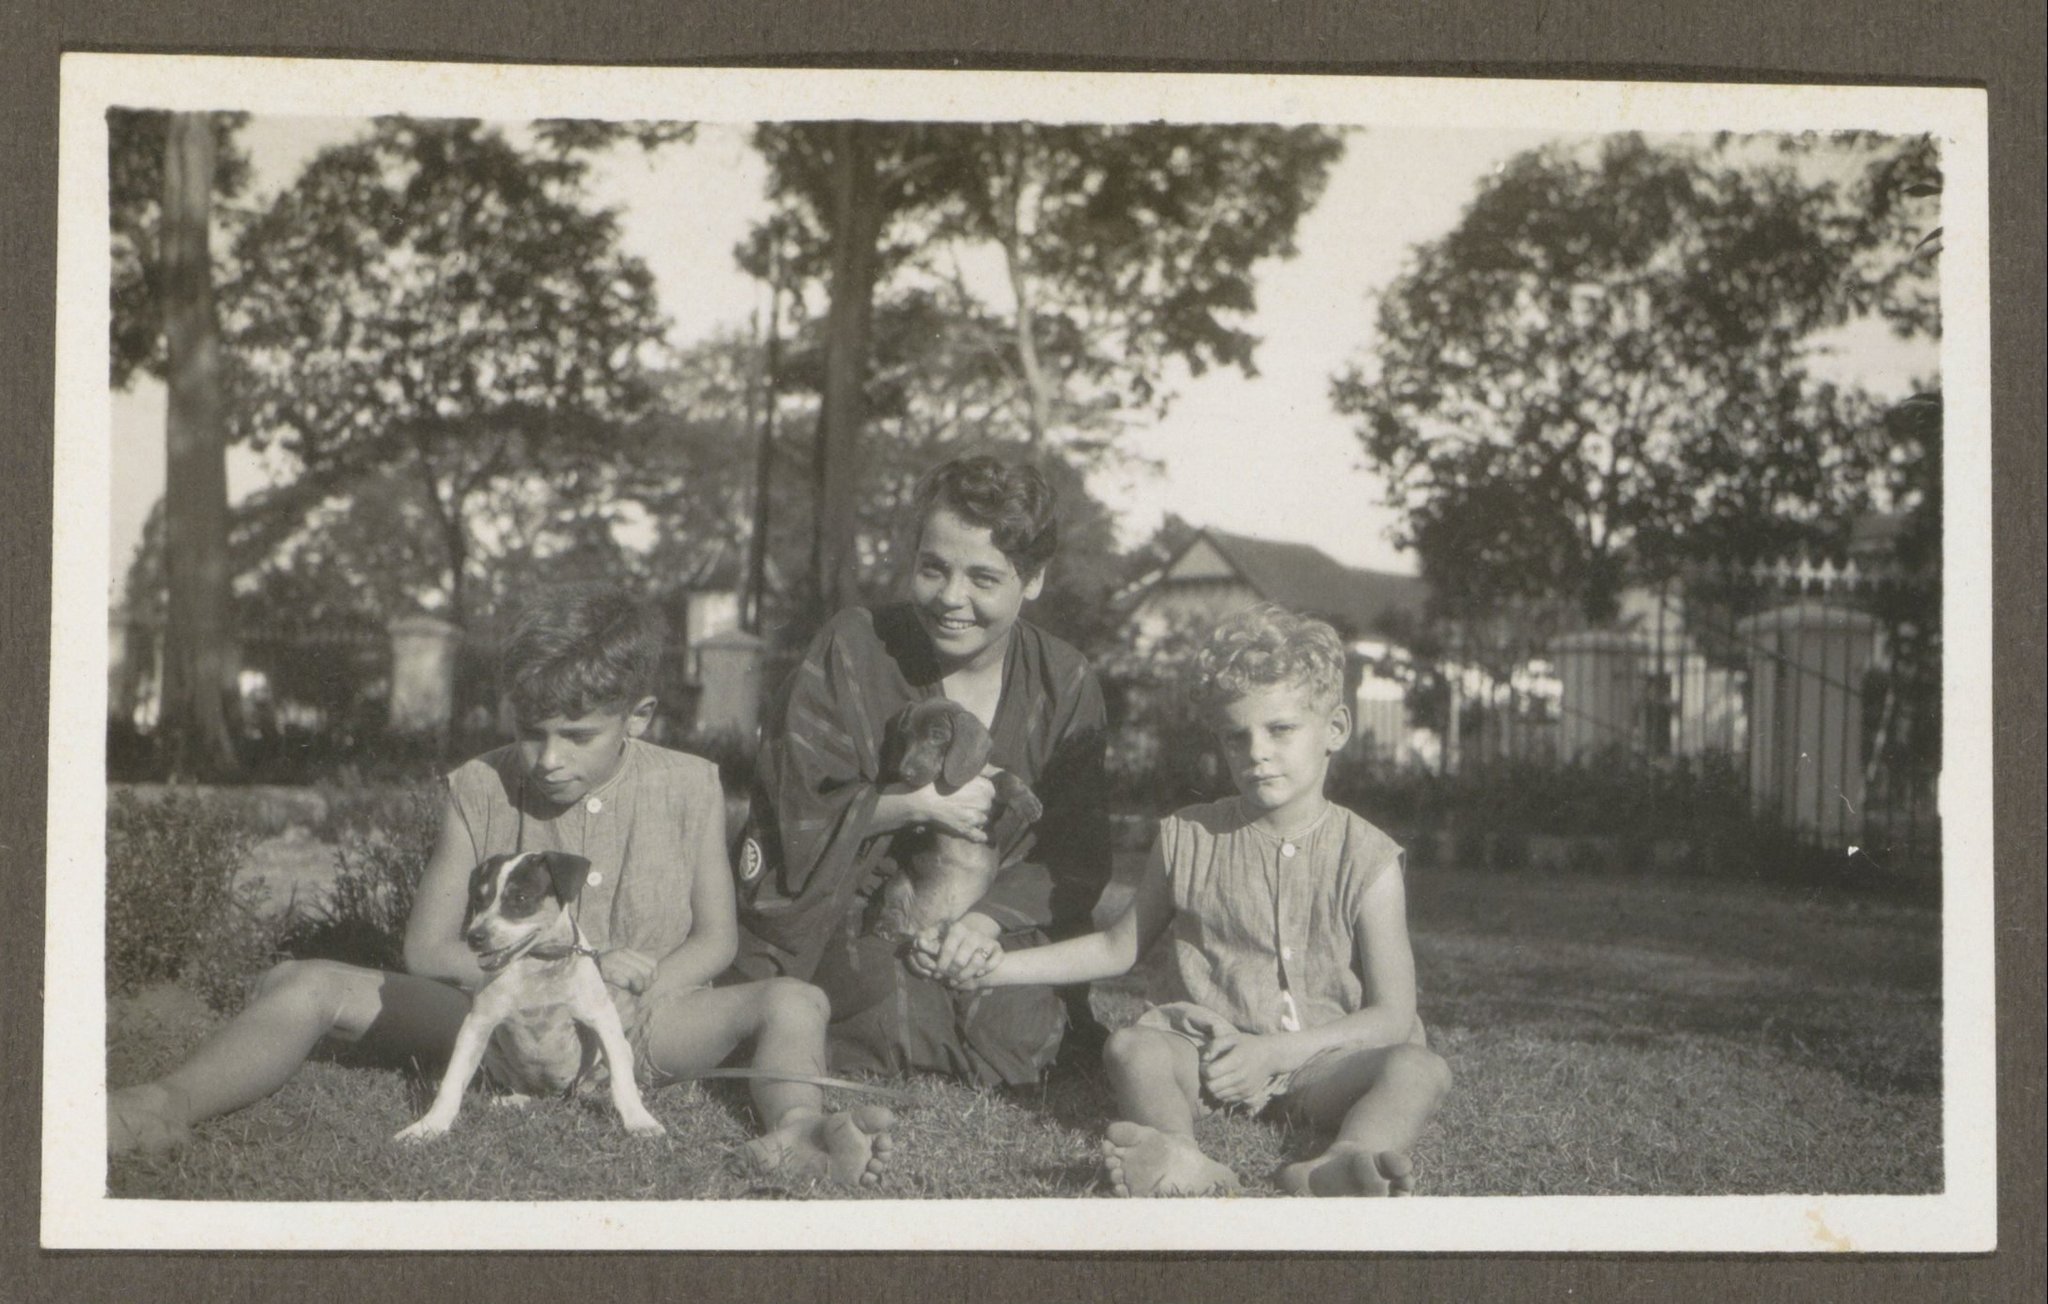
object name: photograph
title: Vrouw met twee kinderen en twee honden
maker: Anonymous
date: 1920-1930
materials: photographic support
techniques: gelatin silver print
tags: friendship between man and animal; caressing, petting, dutch east indies, the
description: Onderdeel van familiealbum Nederlands-Indië.